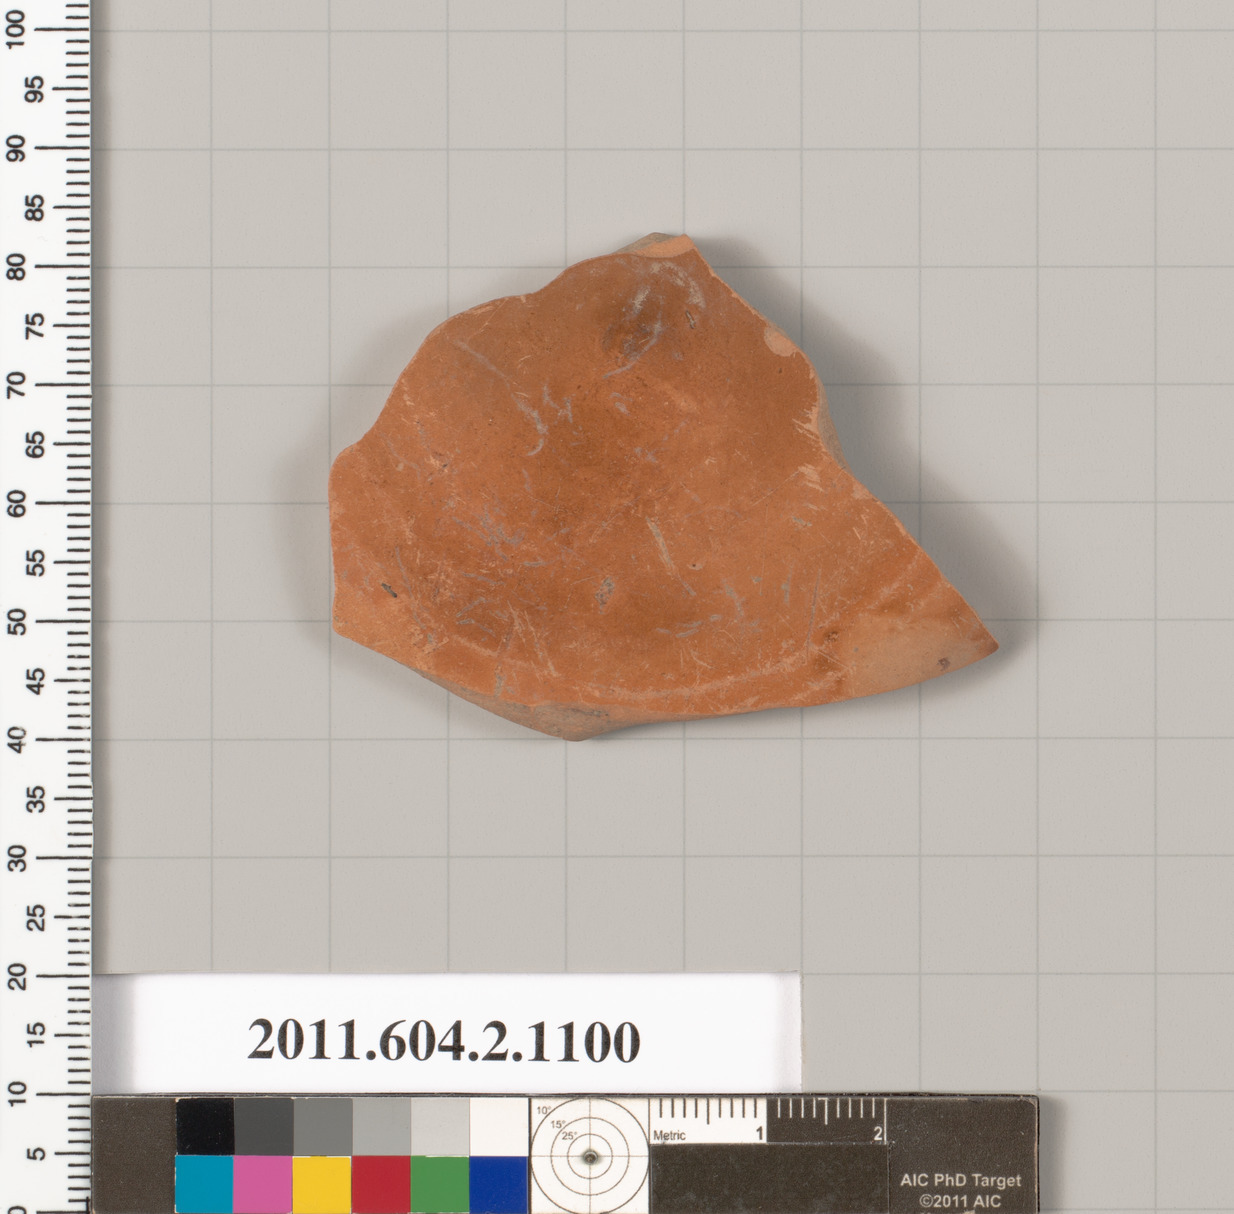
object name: lamp fragment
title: Terracotta fragment of a lamp?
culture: greek, attic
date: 500-451 BCE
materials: terracotta